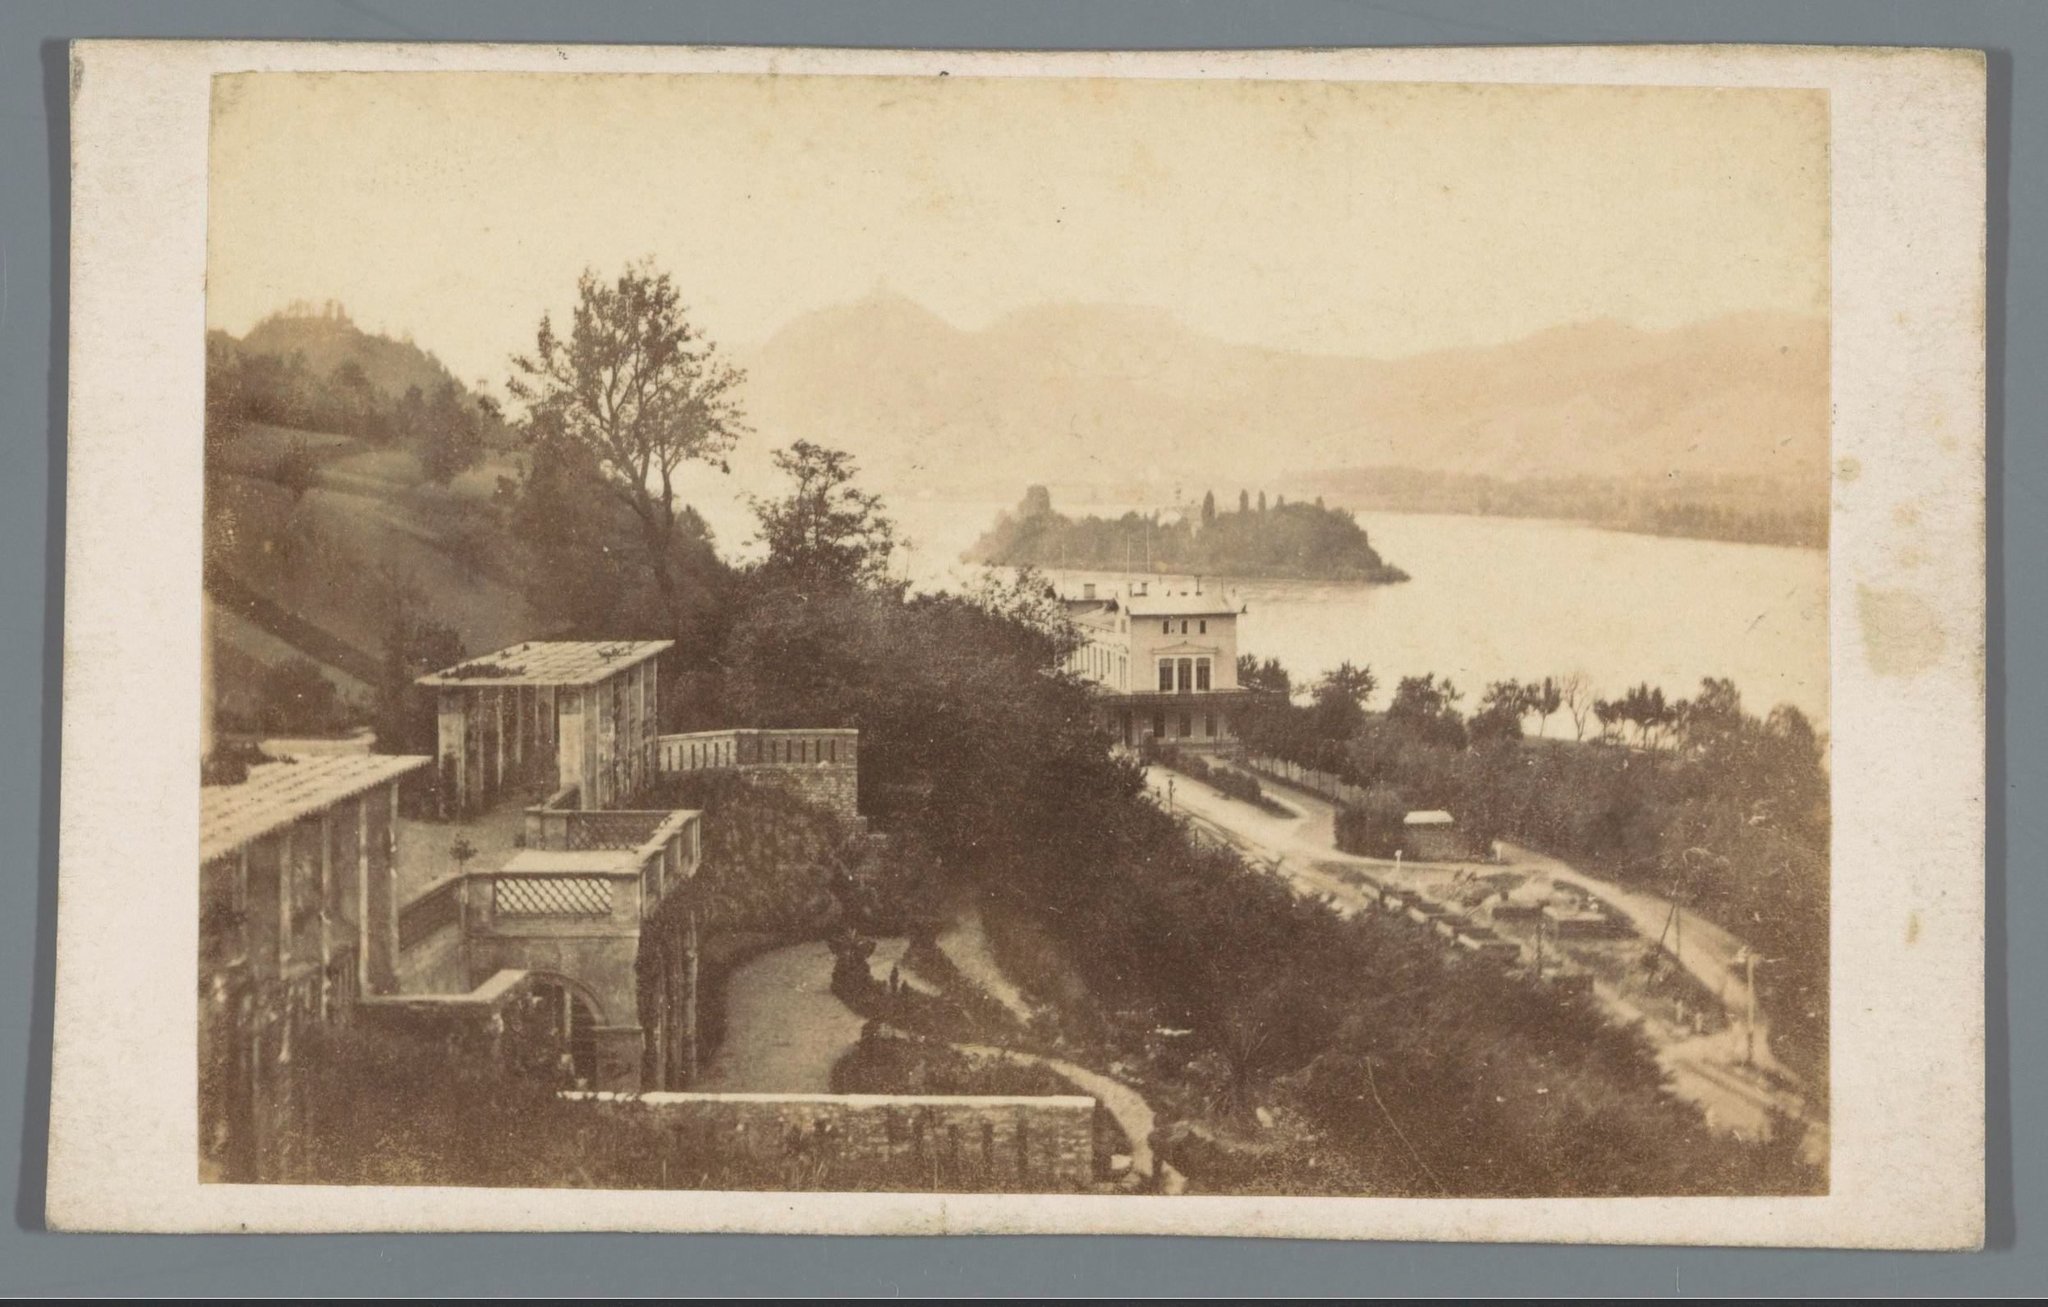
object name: photograph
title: Siebengebirge mit Bahnhof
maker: Anonymous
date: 1855-1885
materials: cardboard, paper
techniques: albumen print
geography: zevengebergte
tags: dale, valley, landscapes with waters, waterscapes, seascapes (in the temperate zone), station; shelter (railway, tramway)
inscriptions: number: ‘Nro. 83.’